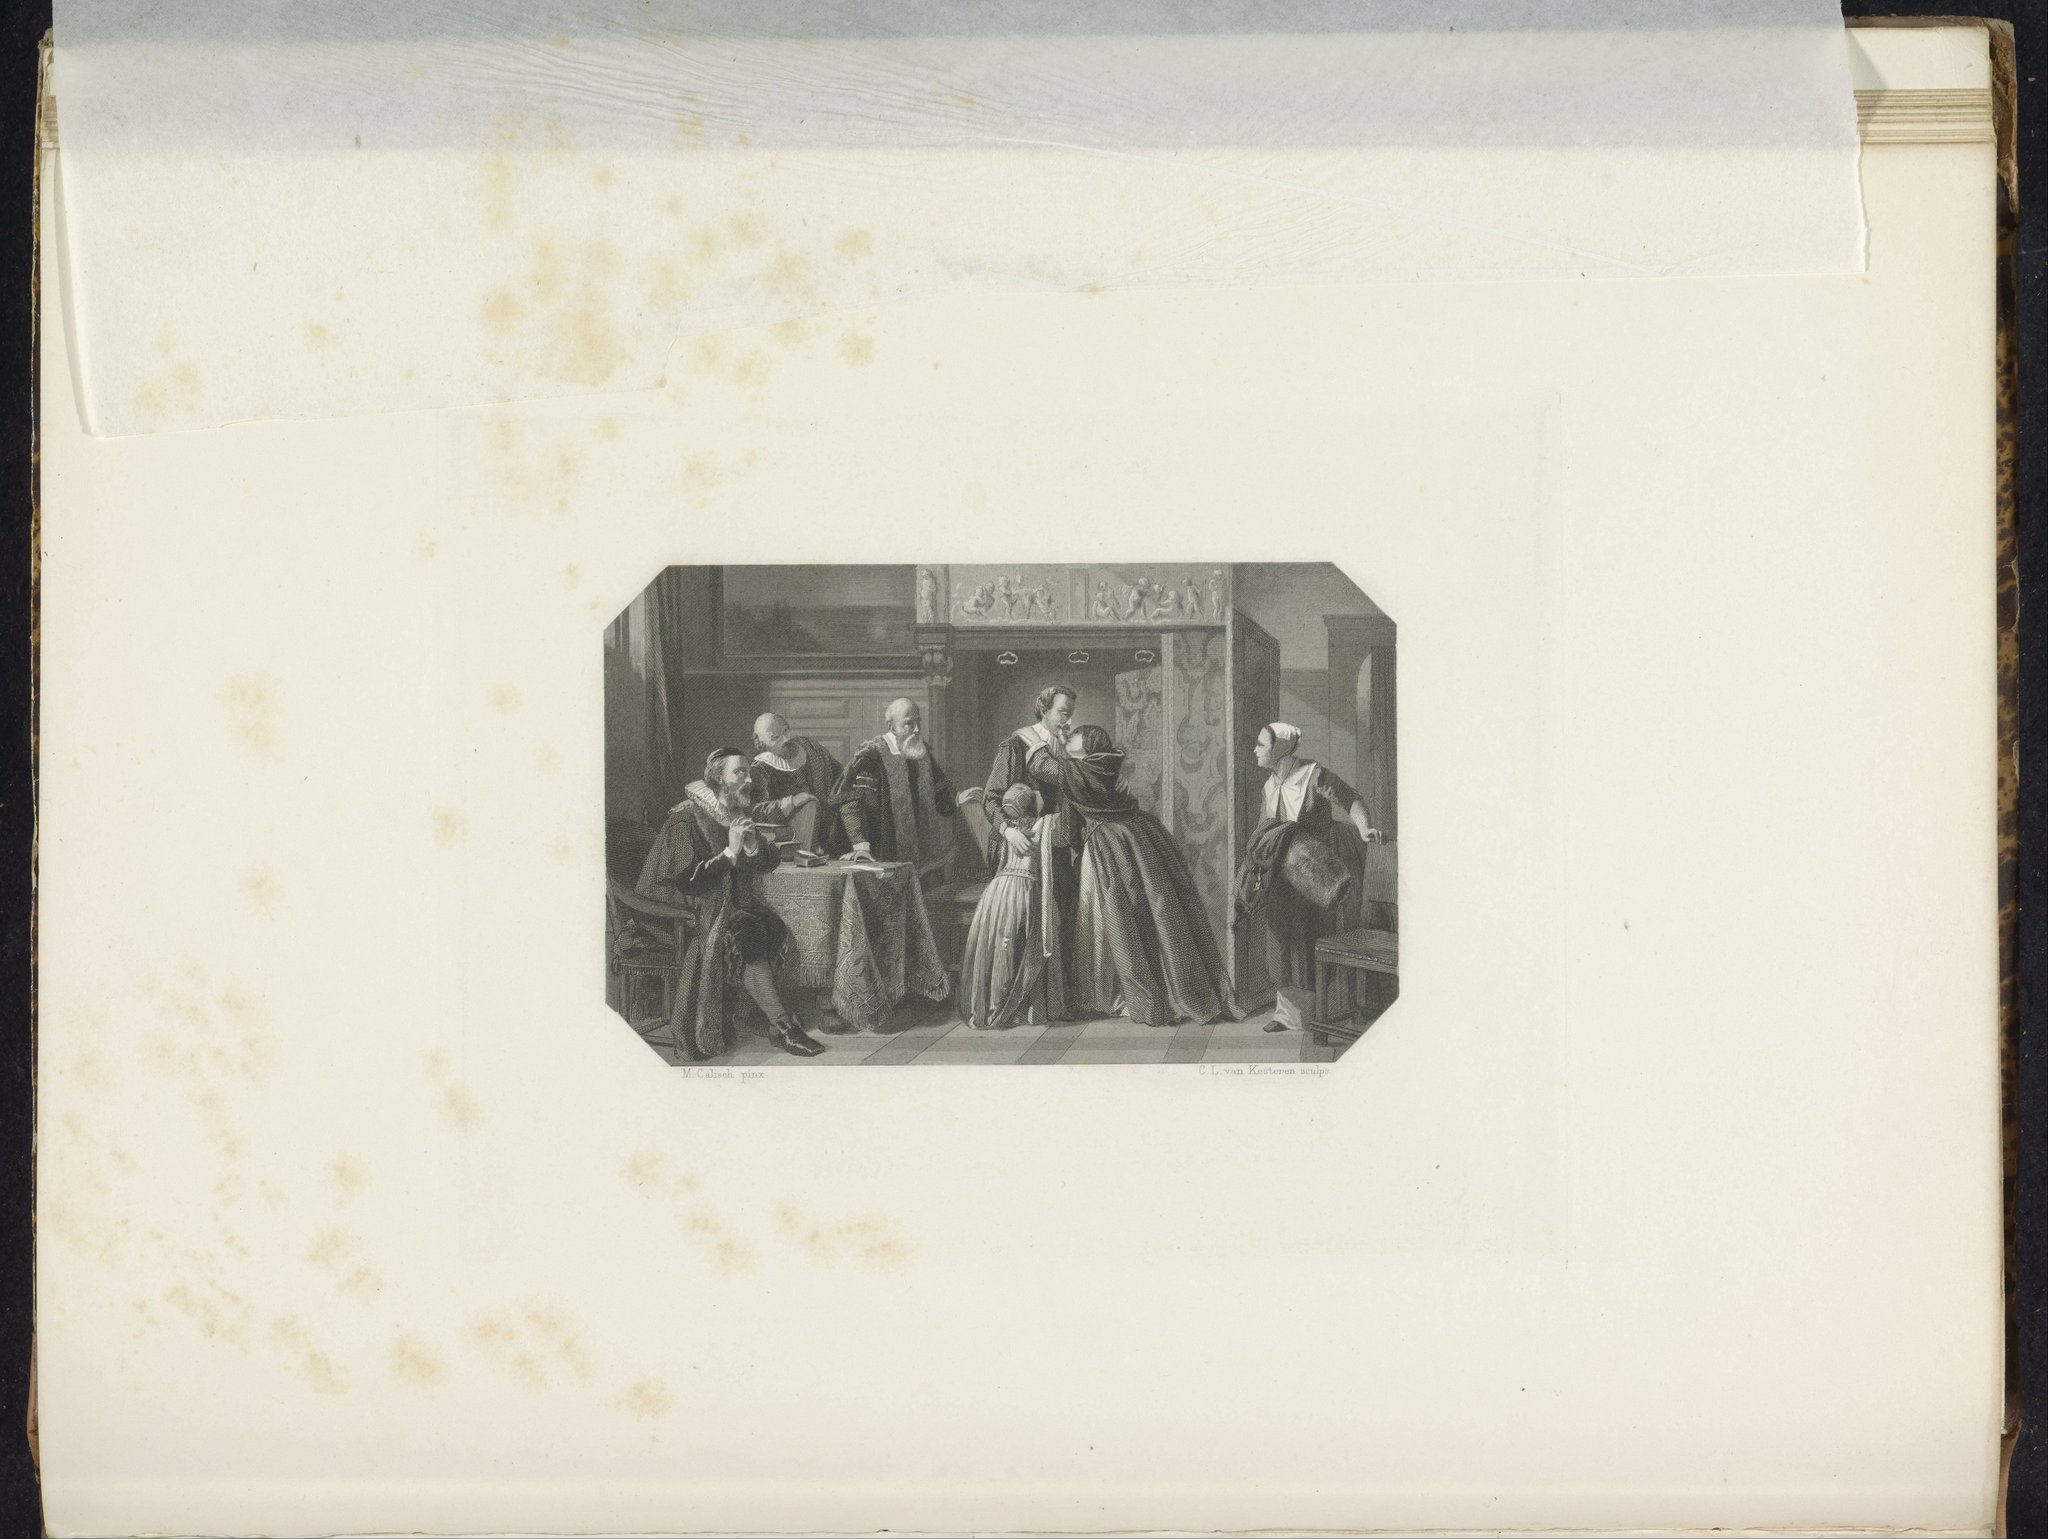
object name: print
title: Hugo de Groot wordt in Parijs herenigd met zijn vrouw Maria van Reigersberch en dochter, 1621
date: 1865-1870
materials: paper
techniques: engraving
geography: netherlands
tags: delft, hugo de groot, paris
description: Hugo de Groot wordt na zijn ontsnapping uit Loevestein in Parijs herenigd met zijn vrouw Maria van Reigersberch, die het plan voor de ontsnapping met de boekenkist had bedacht, en een van hun dochters, september 1621. Onderdeel van de groep staalgravures naar de schilderijen van de Historische Galerij der Maatschappij Arti et Amicitiae.